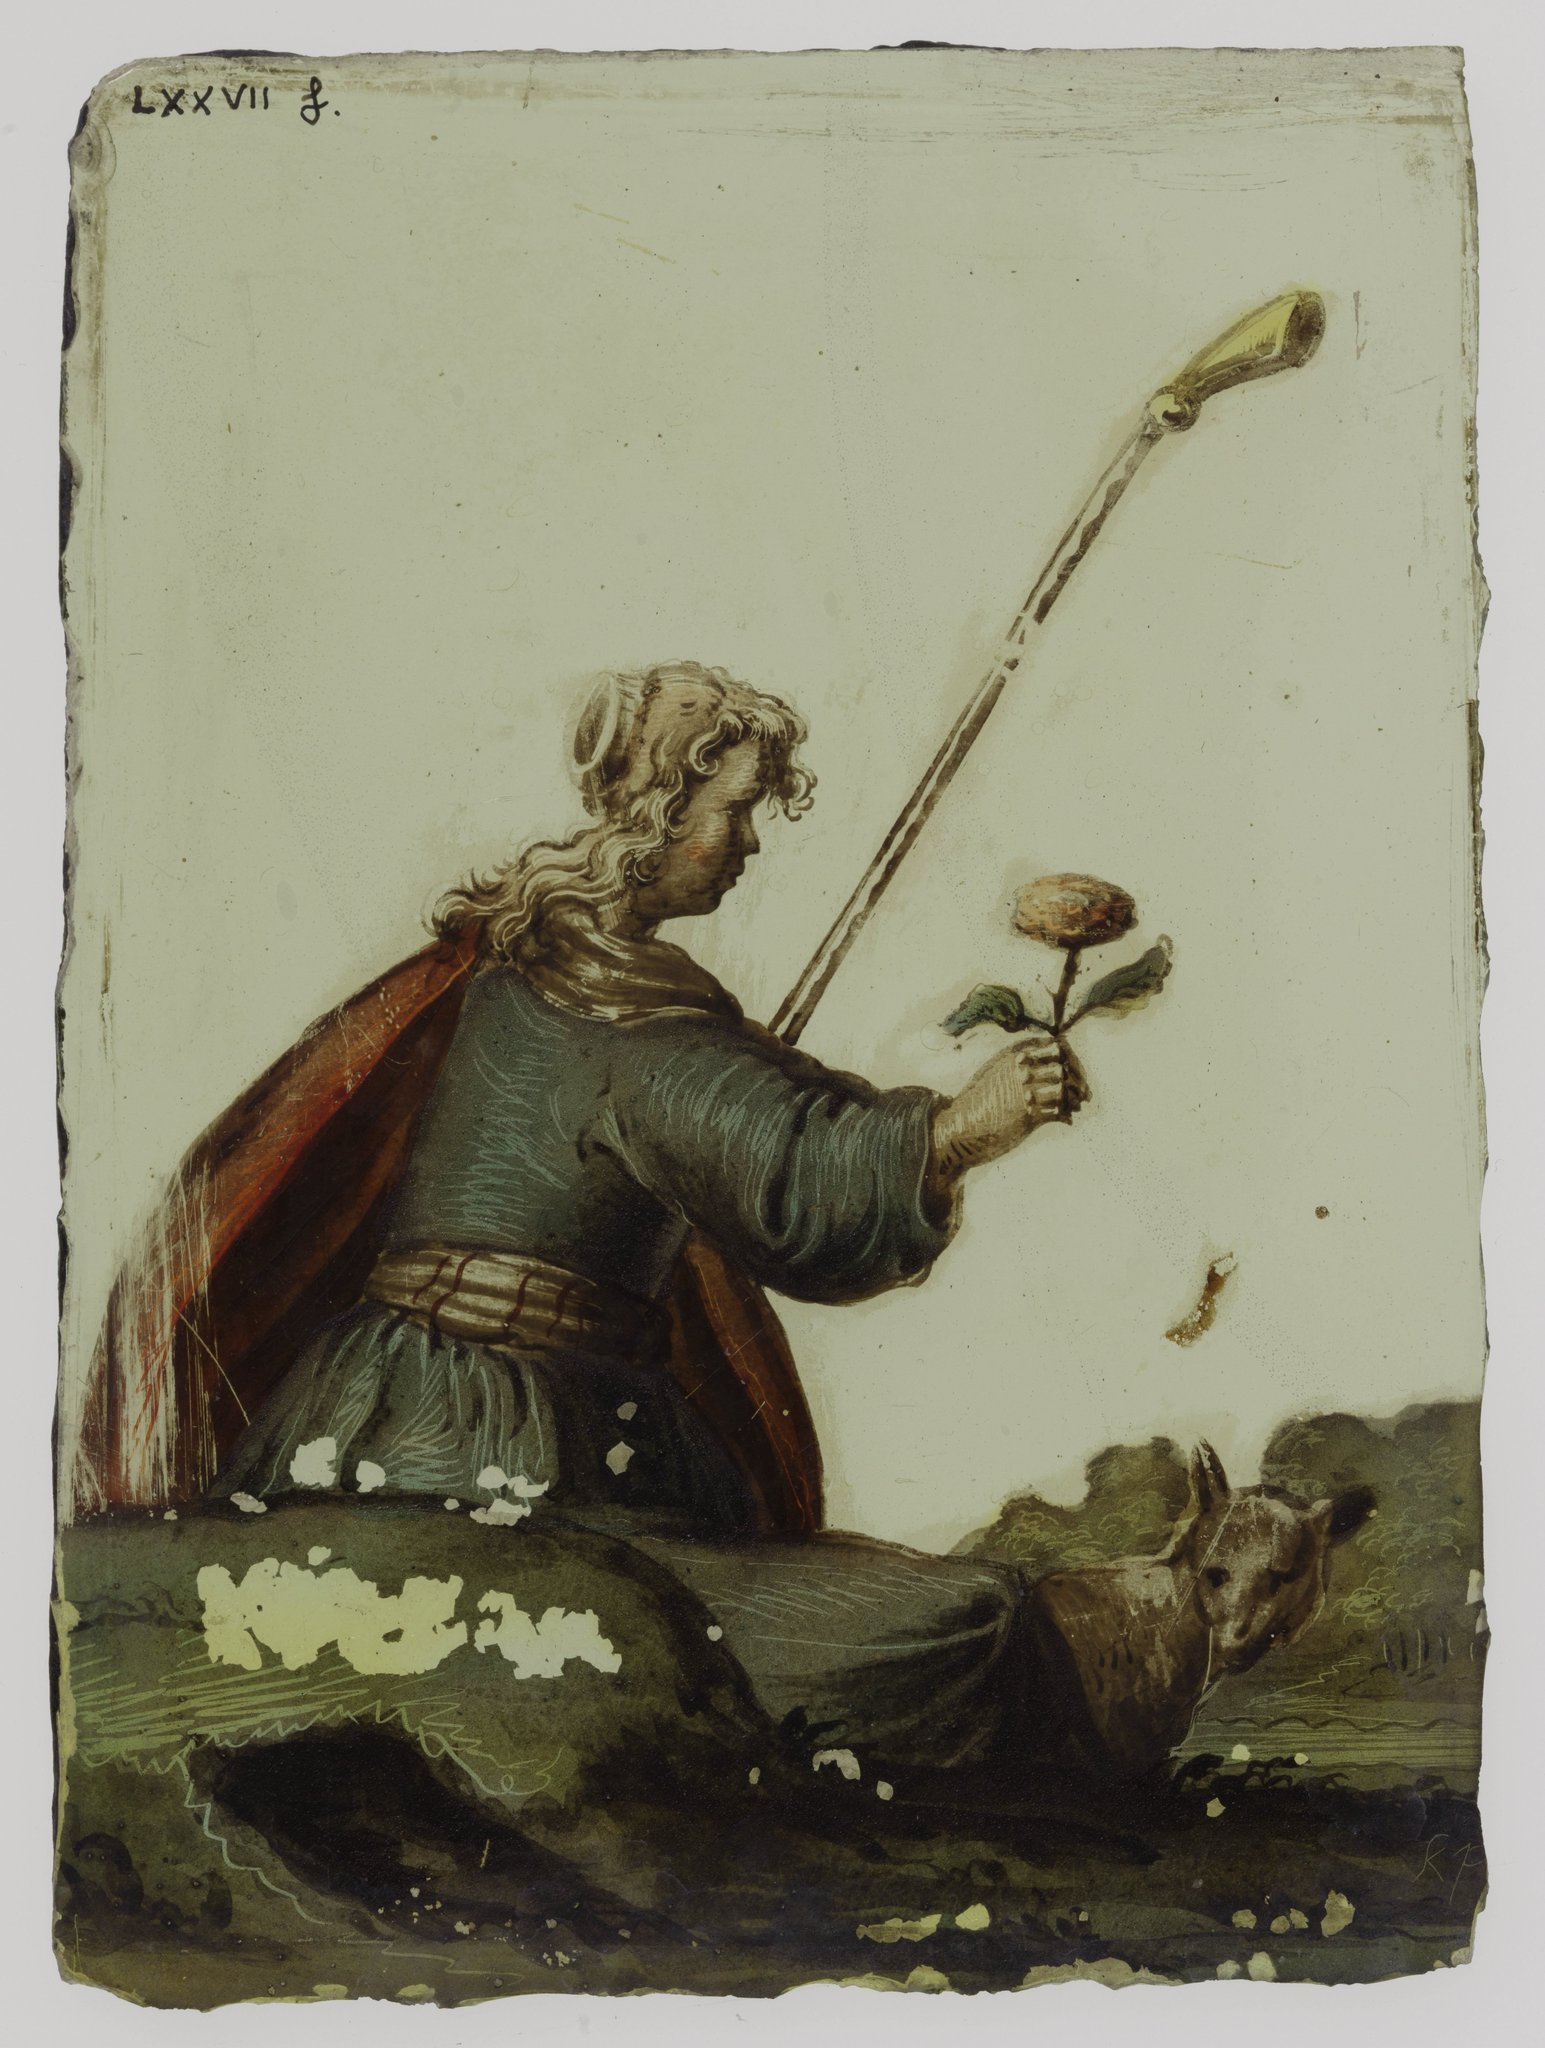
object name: light window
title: Ruit met vrouw met herdersstaf en bloem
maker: Anonymous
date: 1650-1675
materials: glass, lead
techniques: enamel painting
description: Ruit met emailschildering van een vrouw met herdersstaf en bloem.